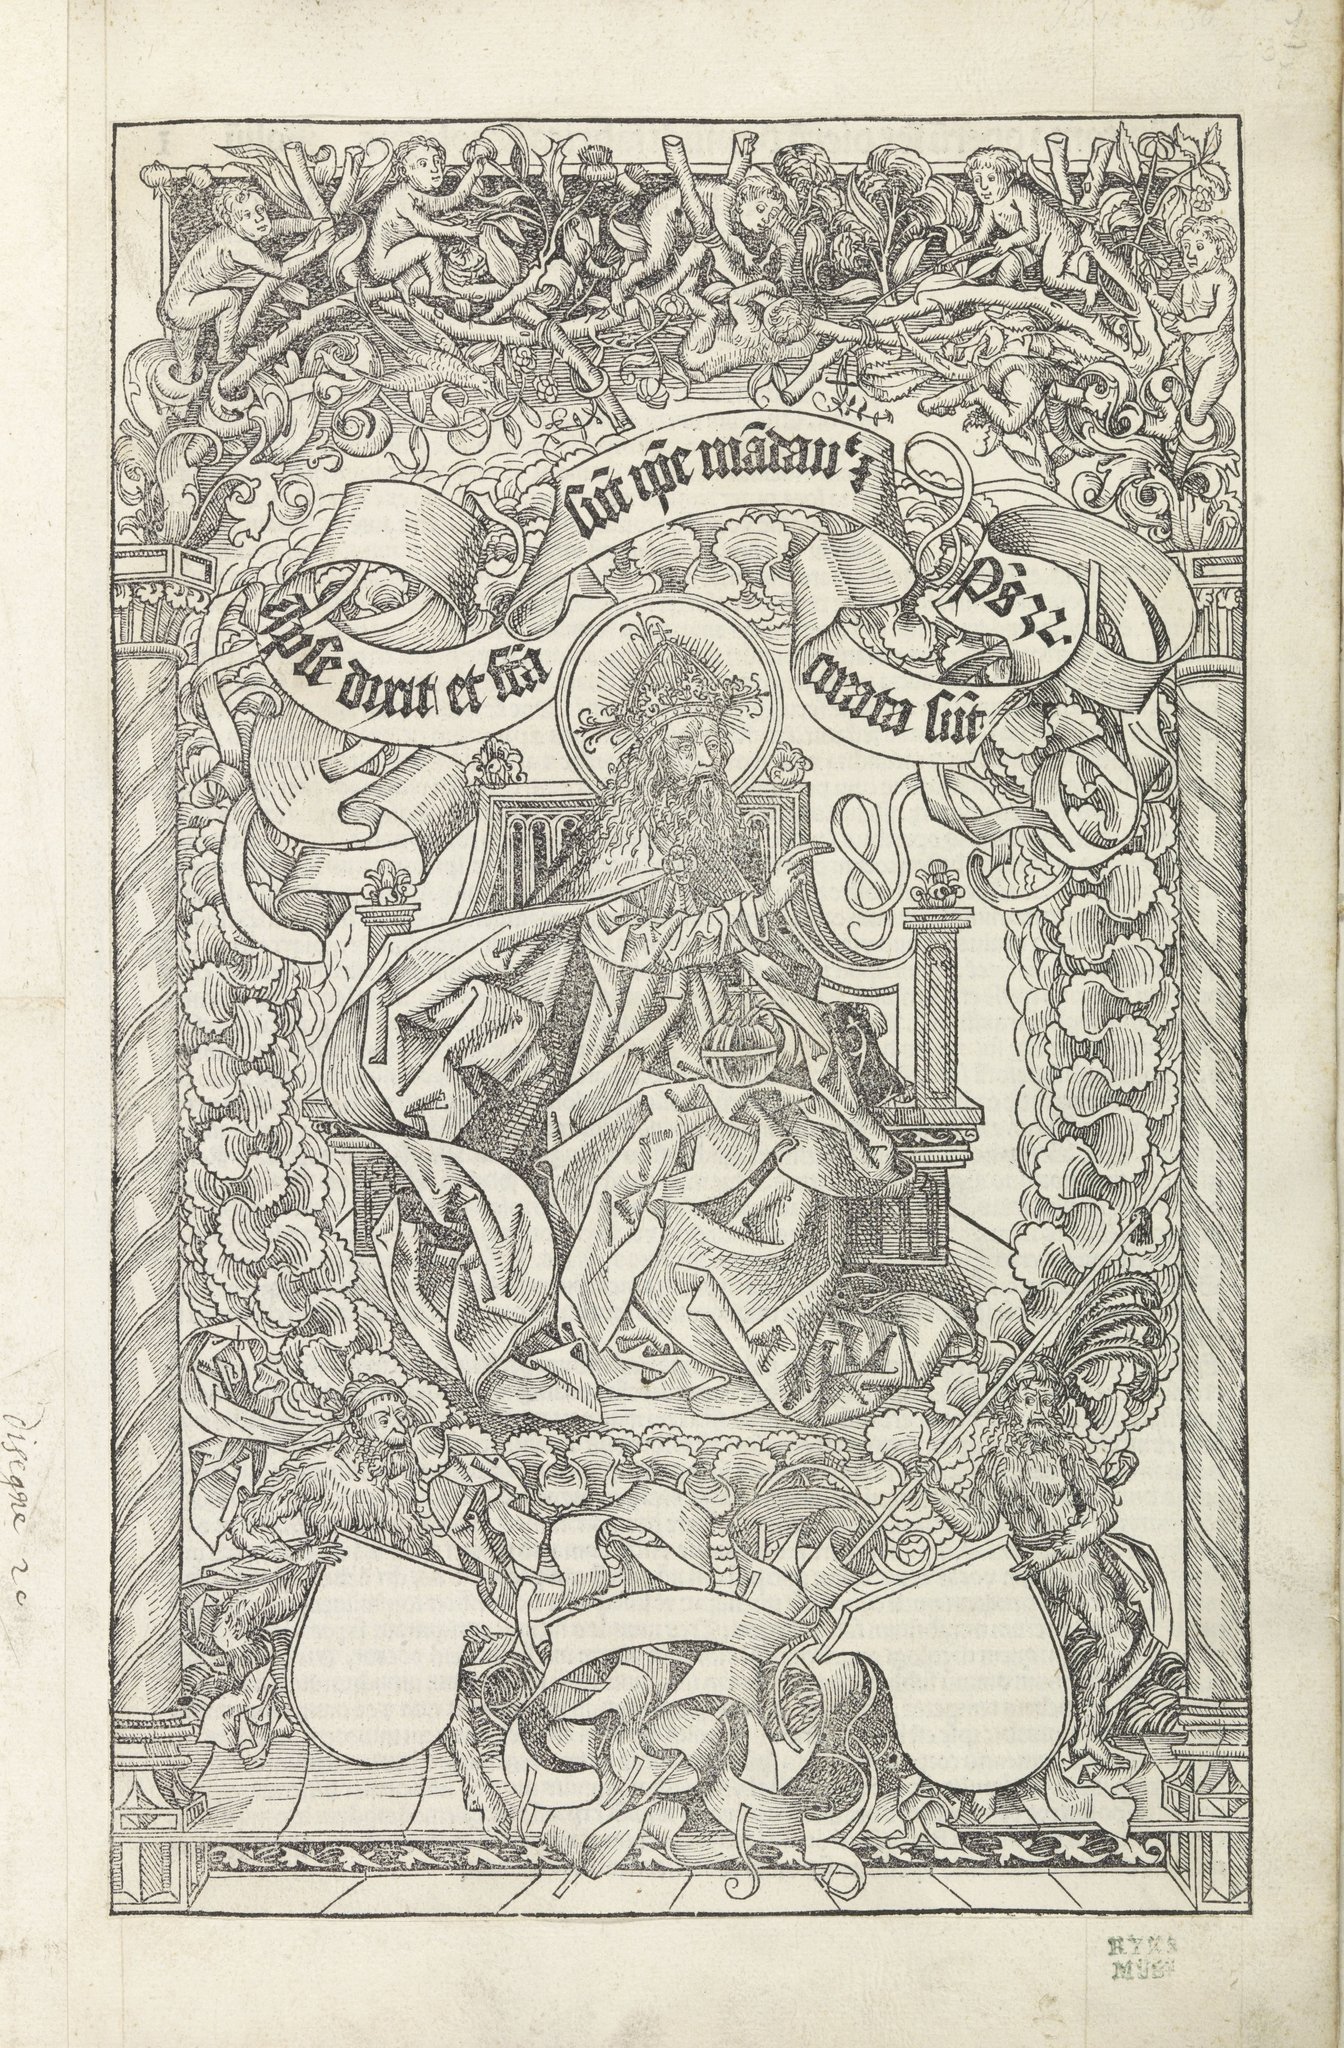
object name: print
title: Titelpagina voor: Hartmann Schedel, Liber Chronicarum, 1493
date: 1493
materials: paper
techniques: letterpress printing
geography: nuremberg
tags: god the father (as bearded old man) enthroned, usually with crown or tiara, and with sceptre and/or globe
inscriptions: collector's mark: Lugt 2166, collector's mark: Lugt 2165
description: God de Vader, gezeten op een troon. Op zijn hoofd draagt hij een tiara. In zijn linkerhand heeft hij een rijksappel. Met zijn rechterhand maakt hij een spreekgebaar. In een banderol de tekst: Ipse dixit et facta sunt, Ipse mandavit, et creata sunt. Psalm 33:9 (Hij sprak en het was er. Hij gebood en zij waren geschapen). Onderaan houden twee mannen een leeg wapenschild vast. Bovenaan een decoratieve rand van verstrengelde takken en naakte figuren. De prent maakt deel uit van een album.